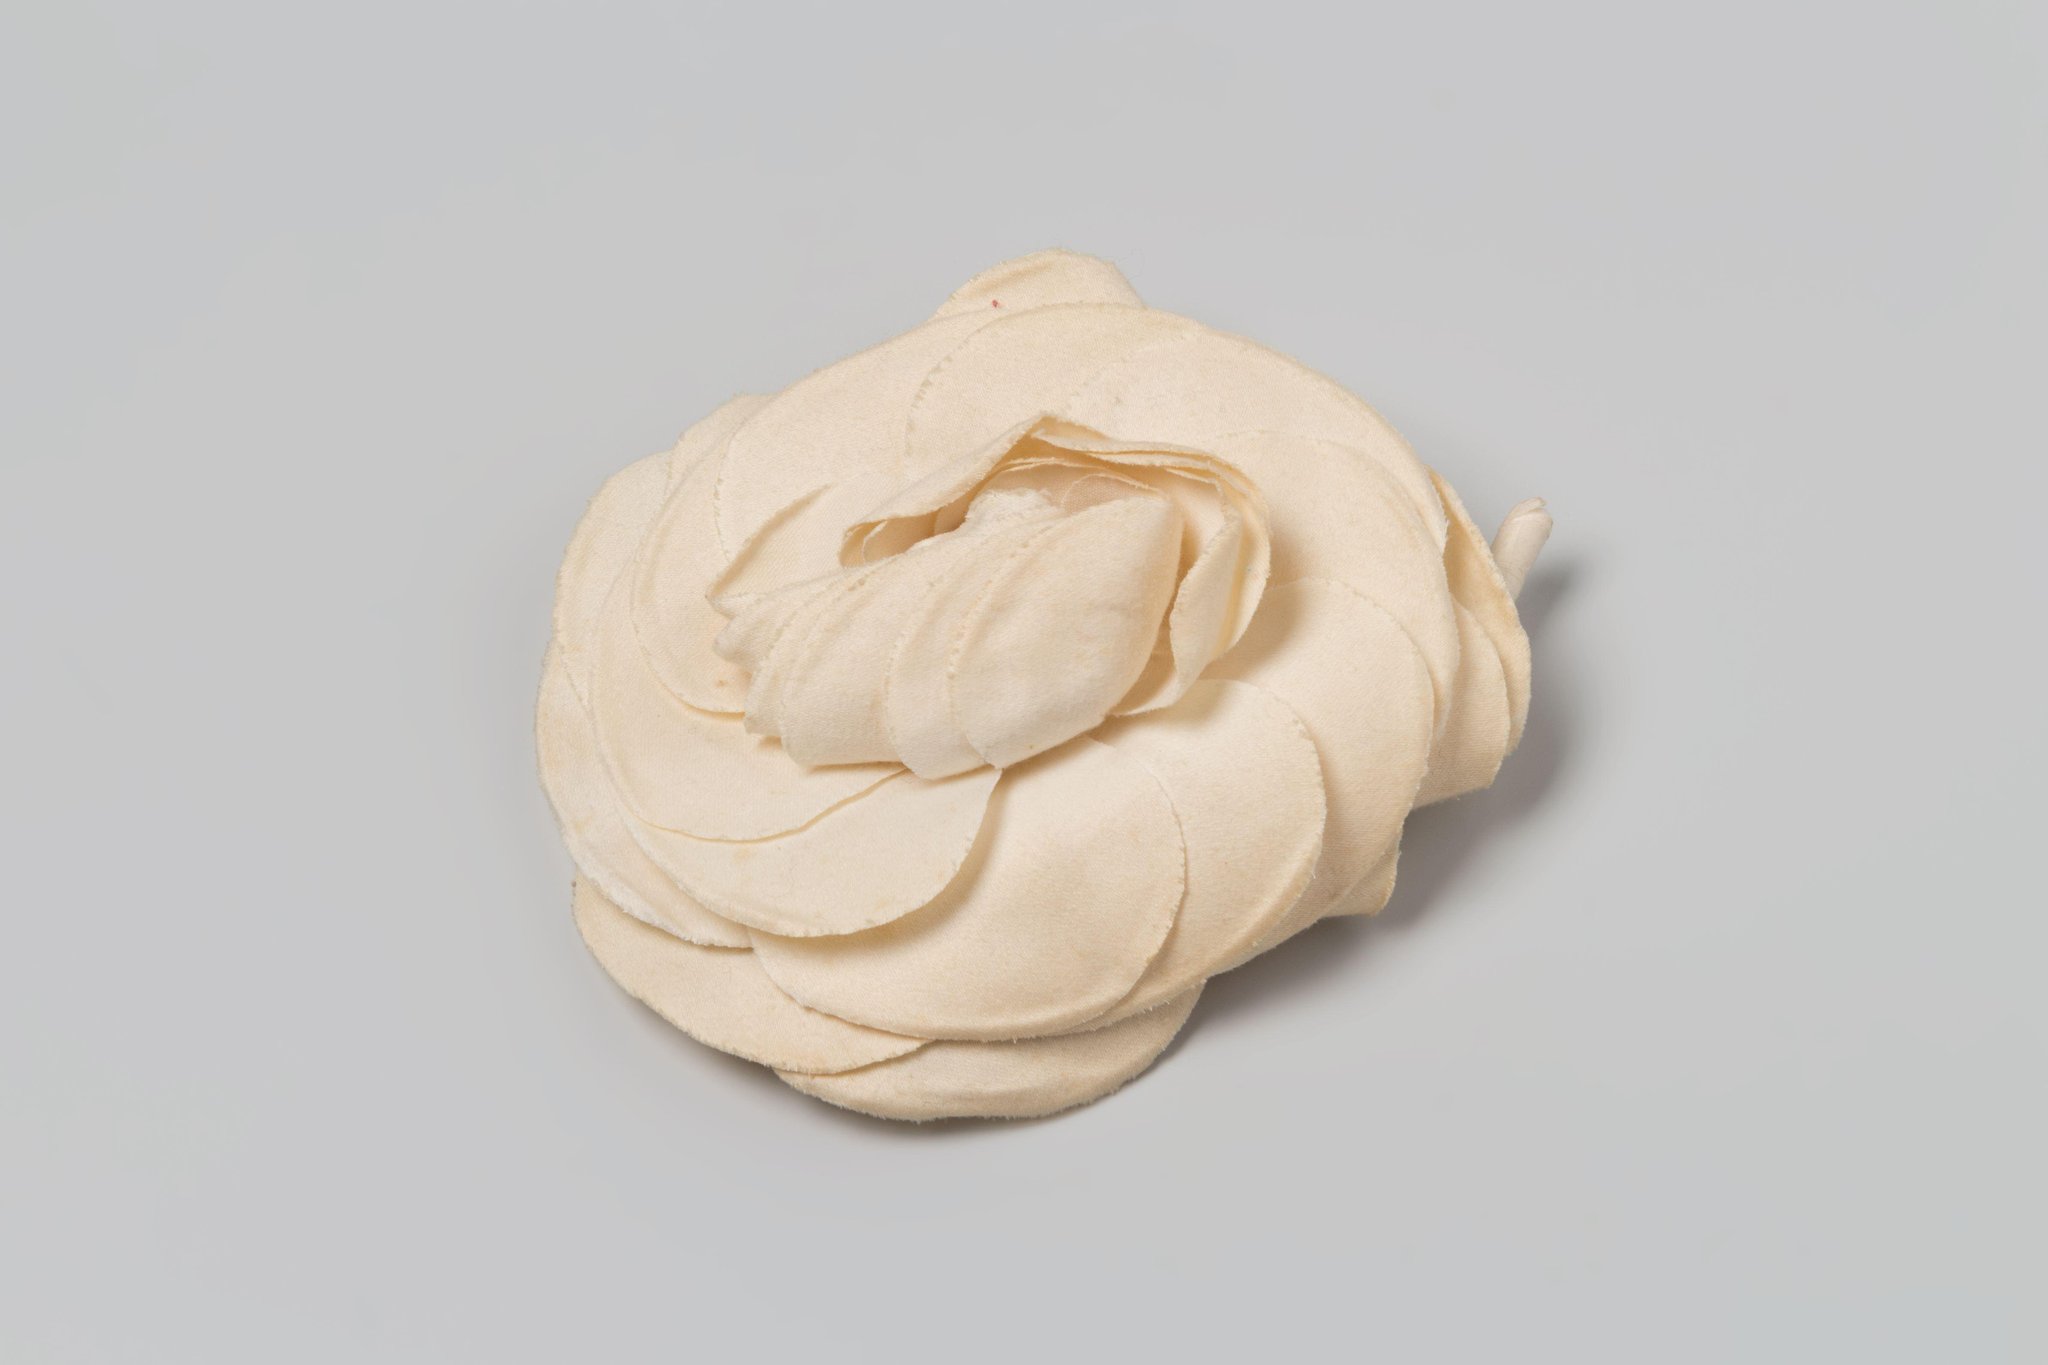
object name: womenswear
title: Corsage, witte roos op witte steel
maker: Anonymous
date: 1930-1950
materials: linen, metal, paper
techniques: wrapping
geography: netherlands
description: Bloemcorsage, witte roos van linnen op een witte steel omwikkeld met papier, waaraan een speld.